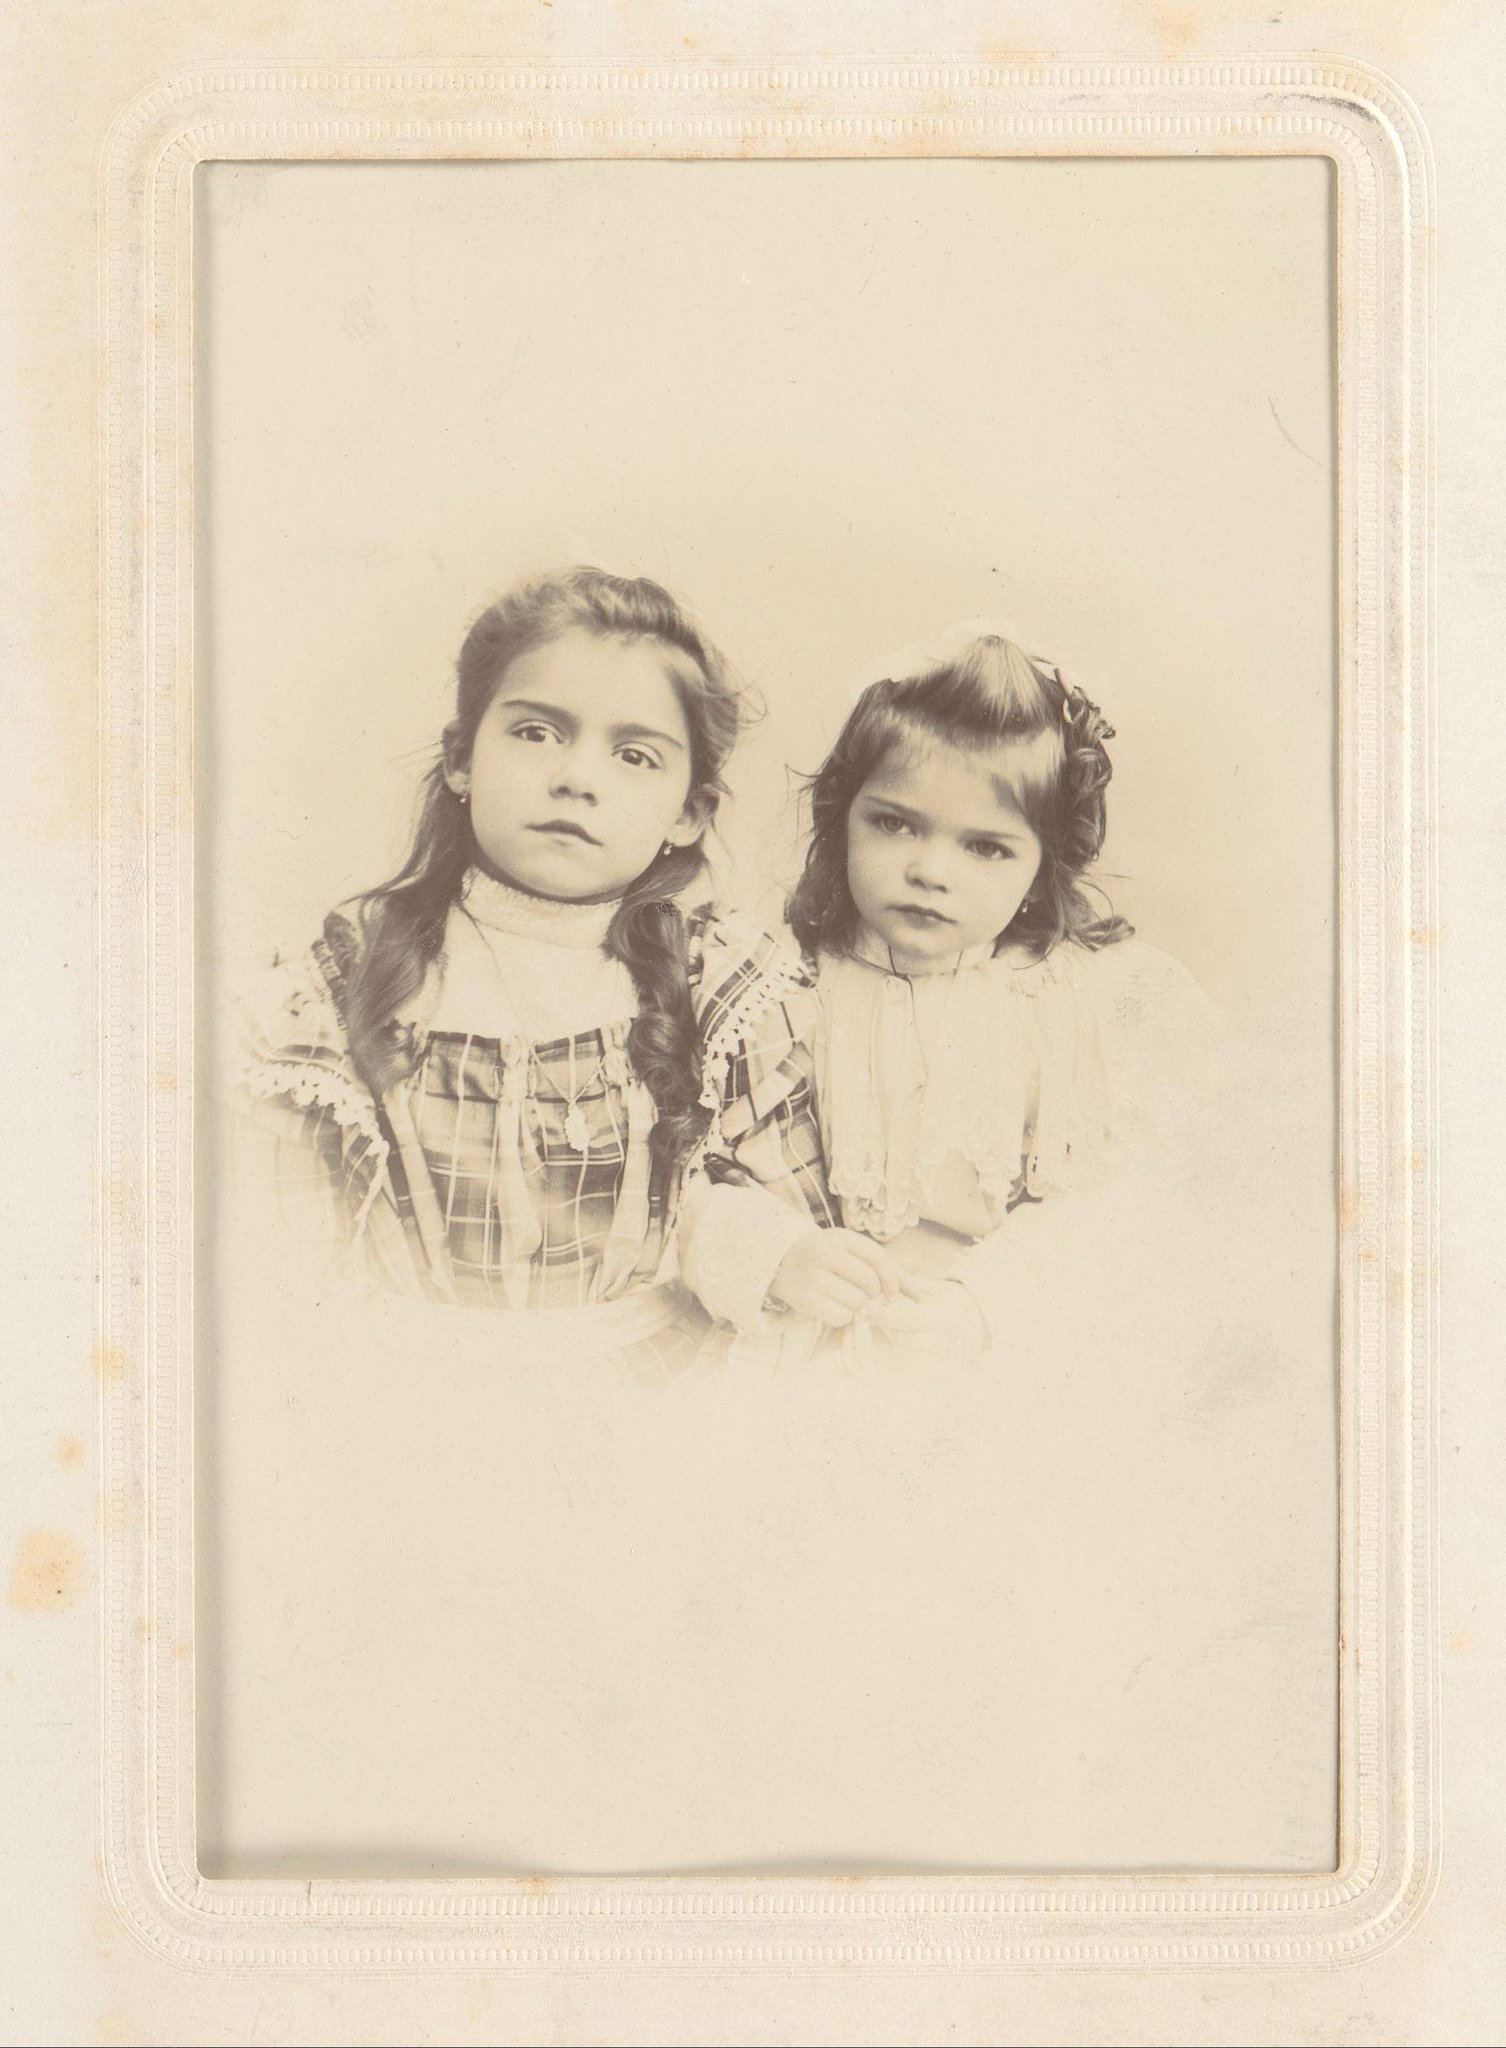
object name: album leaf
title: Portret van twee meisjes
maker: maxime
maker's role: fotograaf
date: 1867-1900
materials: cardboard, photographic support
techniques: matte daylight collodion silver print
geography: paris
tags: historical persons, girl (child between toddler and youth) (+ two persons)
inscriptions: inscription: ‘No. Cirasce/ I Novele moyen/ I Coutans manchettes/ Pressé/ Cadreau L’, inscription: ‘PHOTOGRAPHIE DU POLE NORD/ MAXIME/ 35, Rue de Clichy, 35/ PARIS’